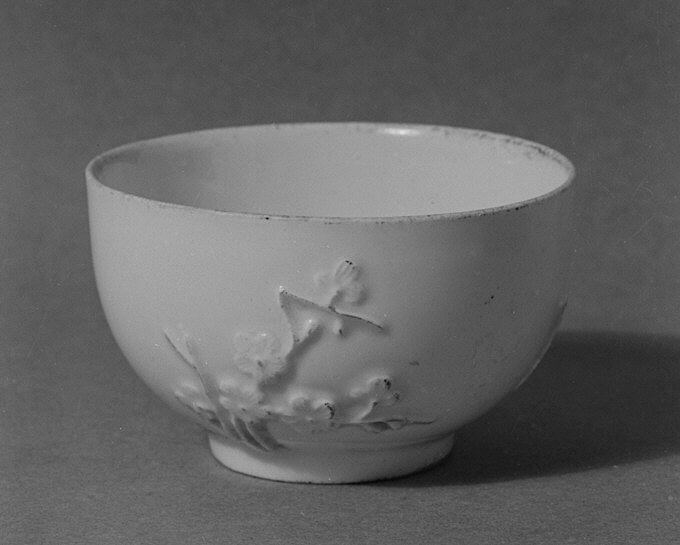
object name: cup and saucer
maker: meissen manufactory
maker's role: manufactory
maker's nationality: german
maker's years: 1710-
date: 1740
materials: hard paste porcelain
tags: flowers